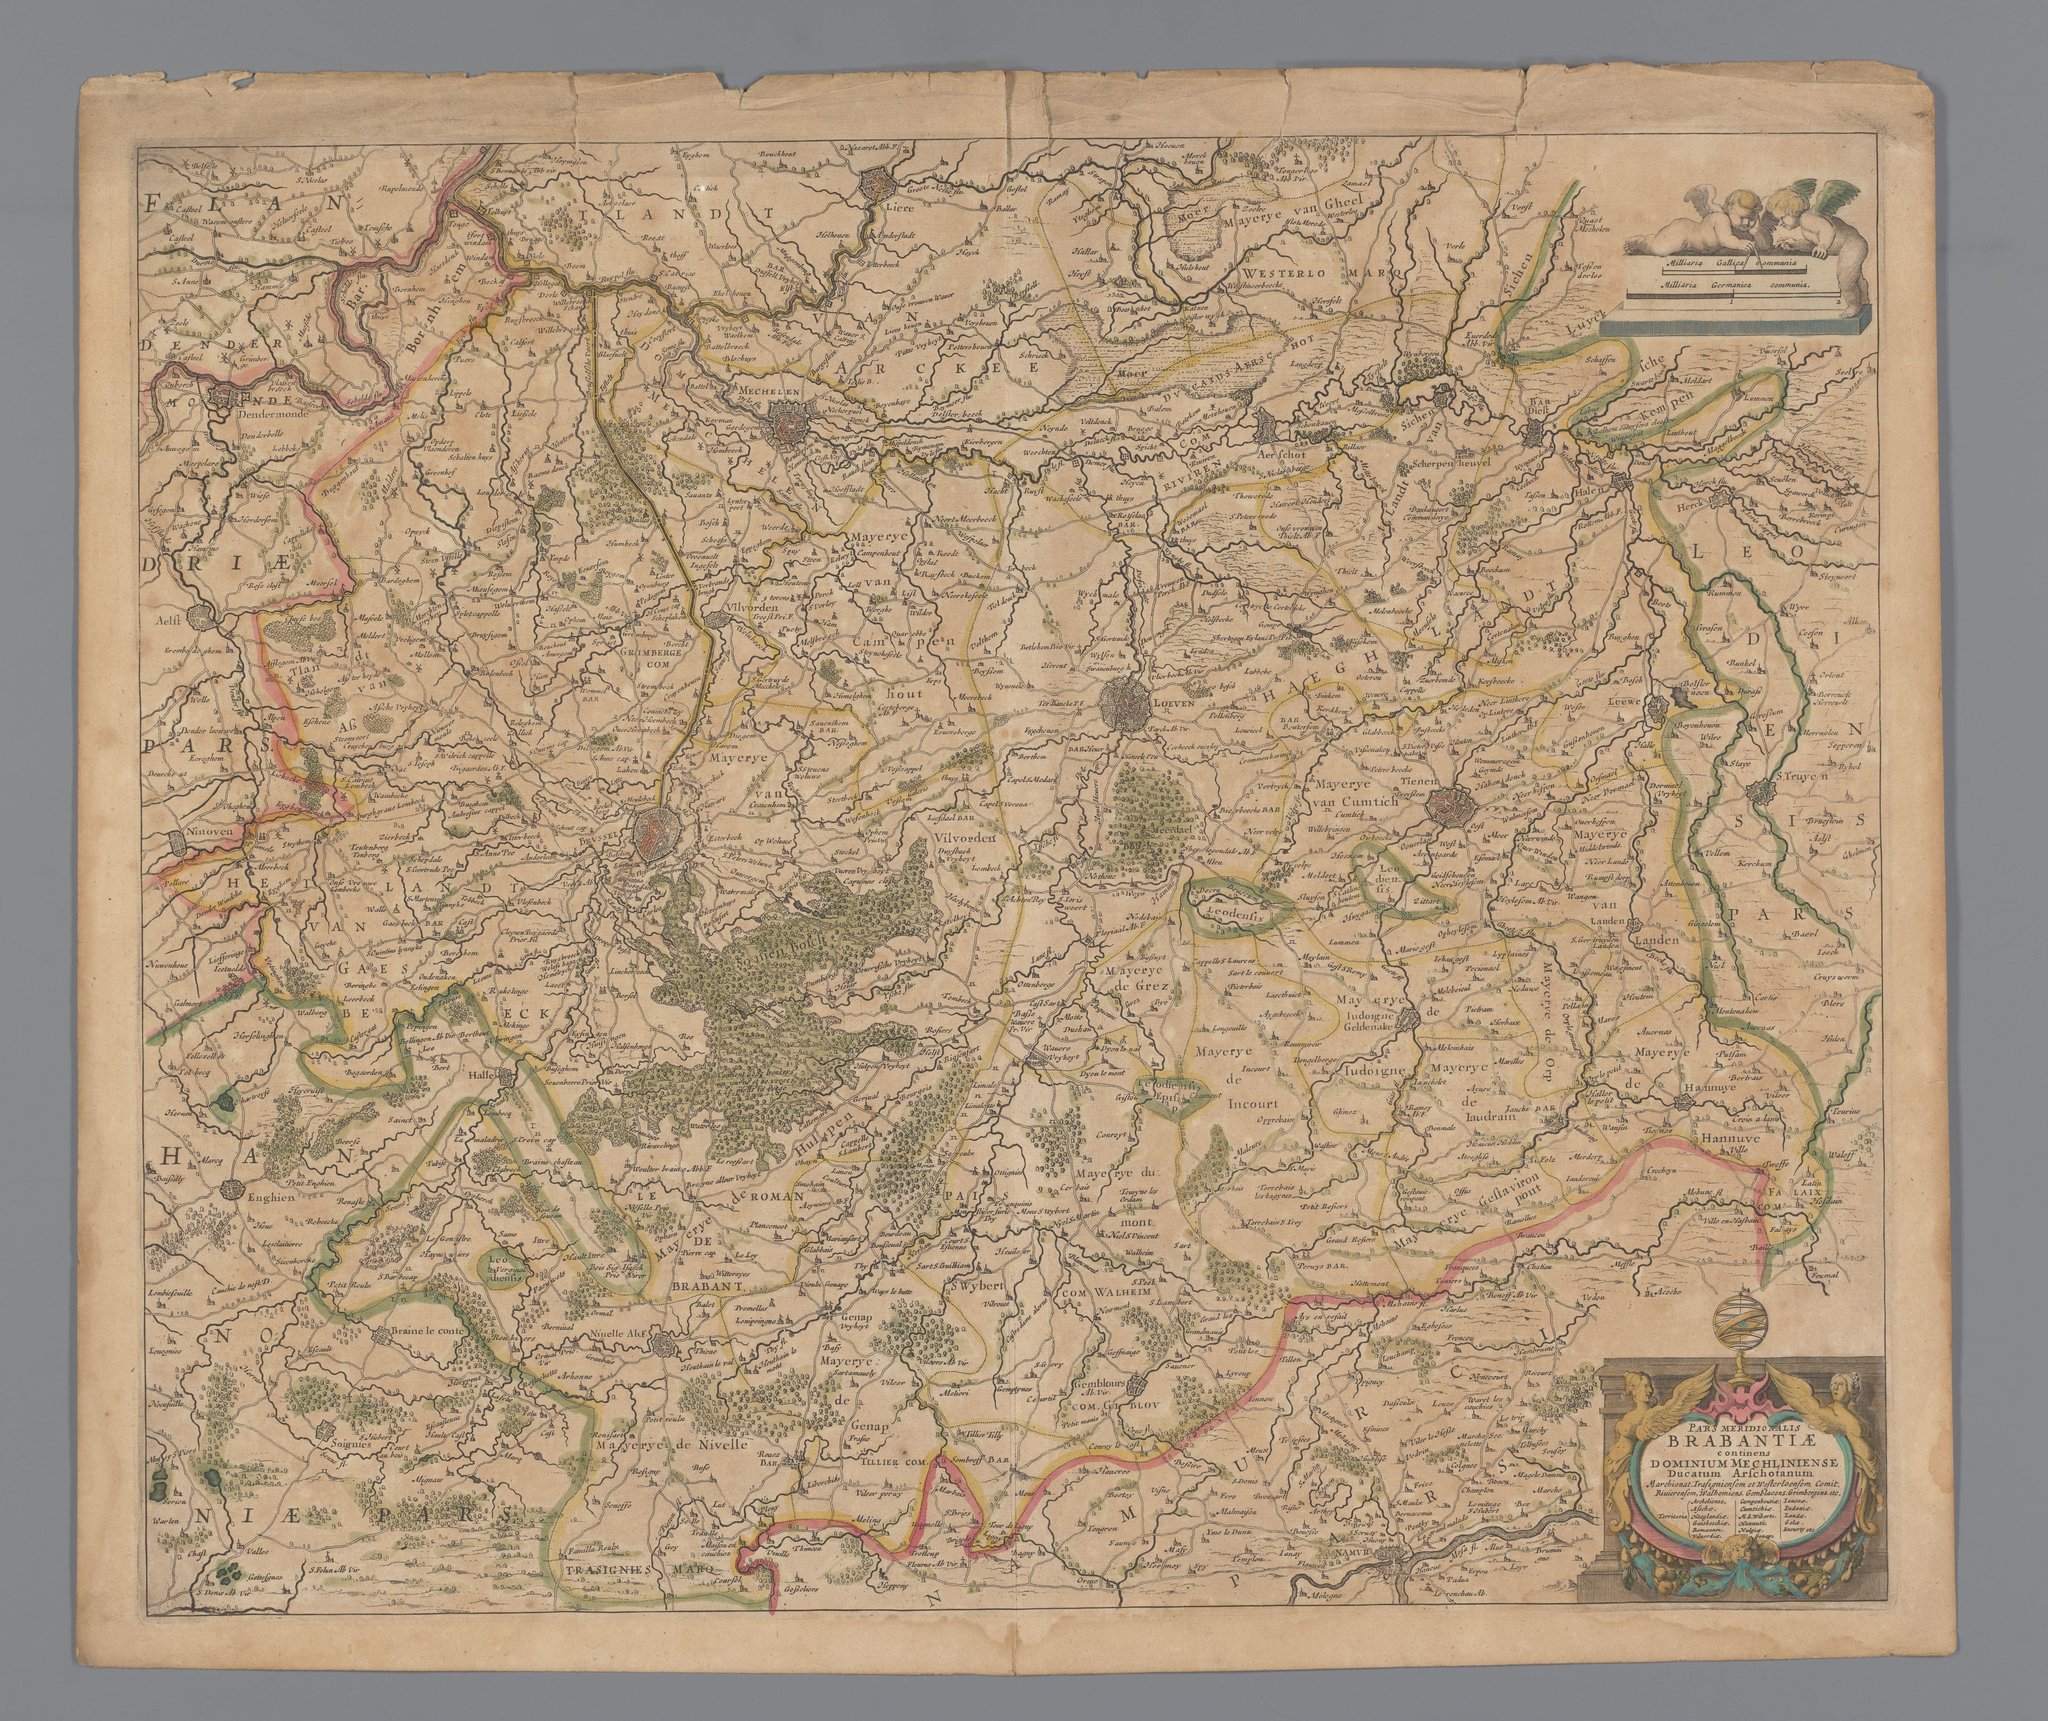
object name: book illustration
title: Brabantiae pars septentrionalis continens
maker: Anonymous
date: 1638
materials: paper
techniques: etching, hand coloring, letterpress printing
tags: maps of separate countries or regions, brabant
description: Prent gebruikt in: Mercator, Gerard, en Jodocus Hondius. Atlas Novus sive descriptio Geographica totius Orbis Terrarum, Tabulis Aeneis Luculentissimis & Accuratissimis Exornata, Tribus Tomis Distinctus. Amsterdam: Henricus Hondius, 1638. Of: Mercator, Gerard, en Jodocus Hondius. Atlas Novus sive descriptio Geographica totius Orbis Terrarum, Tabulis Aeneis Luculentissimis & Accuratissimis Exornata, Tribus Tomis Distinctus. Amsterdam: Johannes Janssonius, 1638.